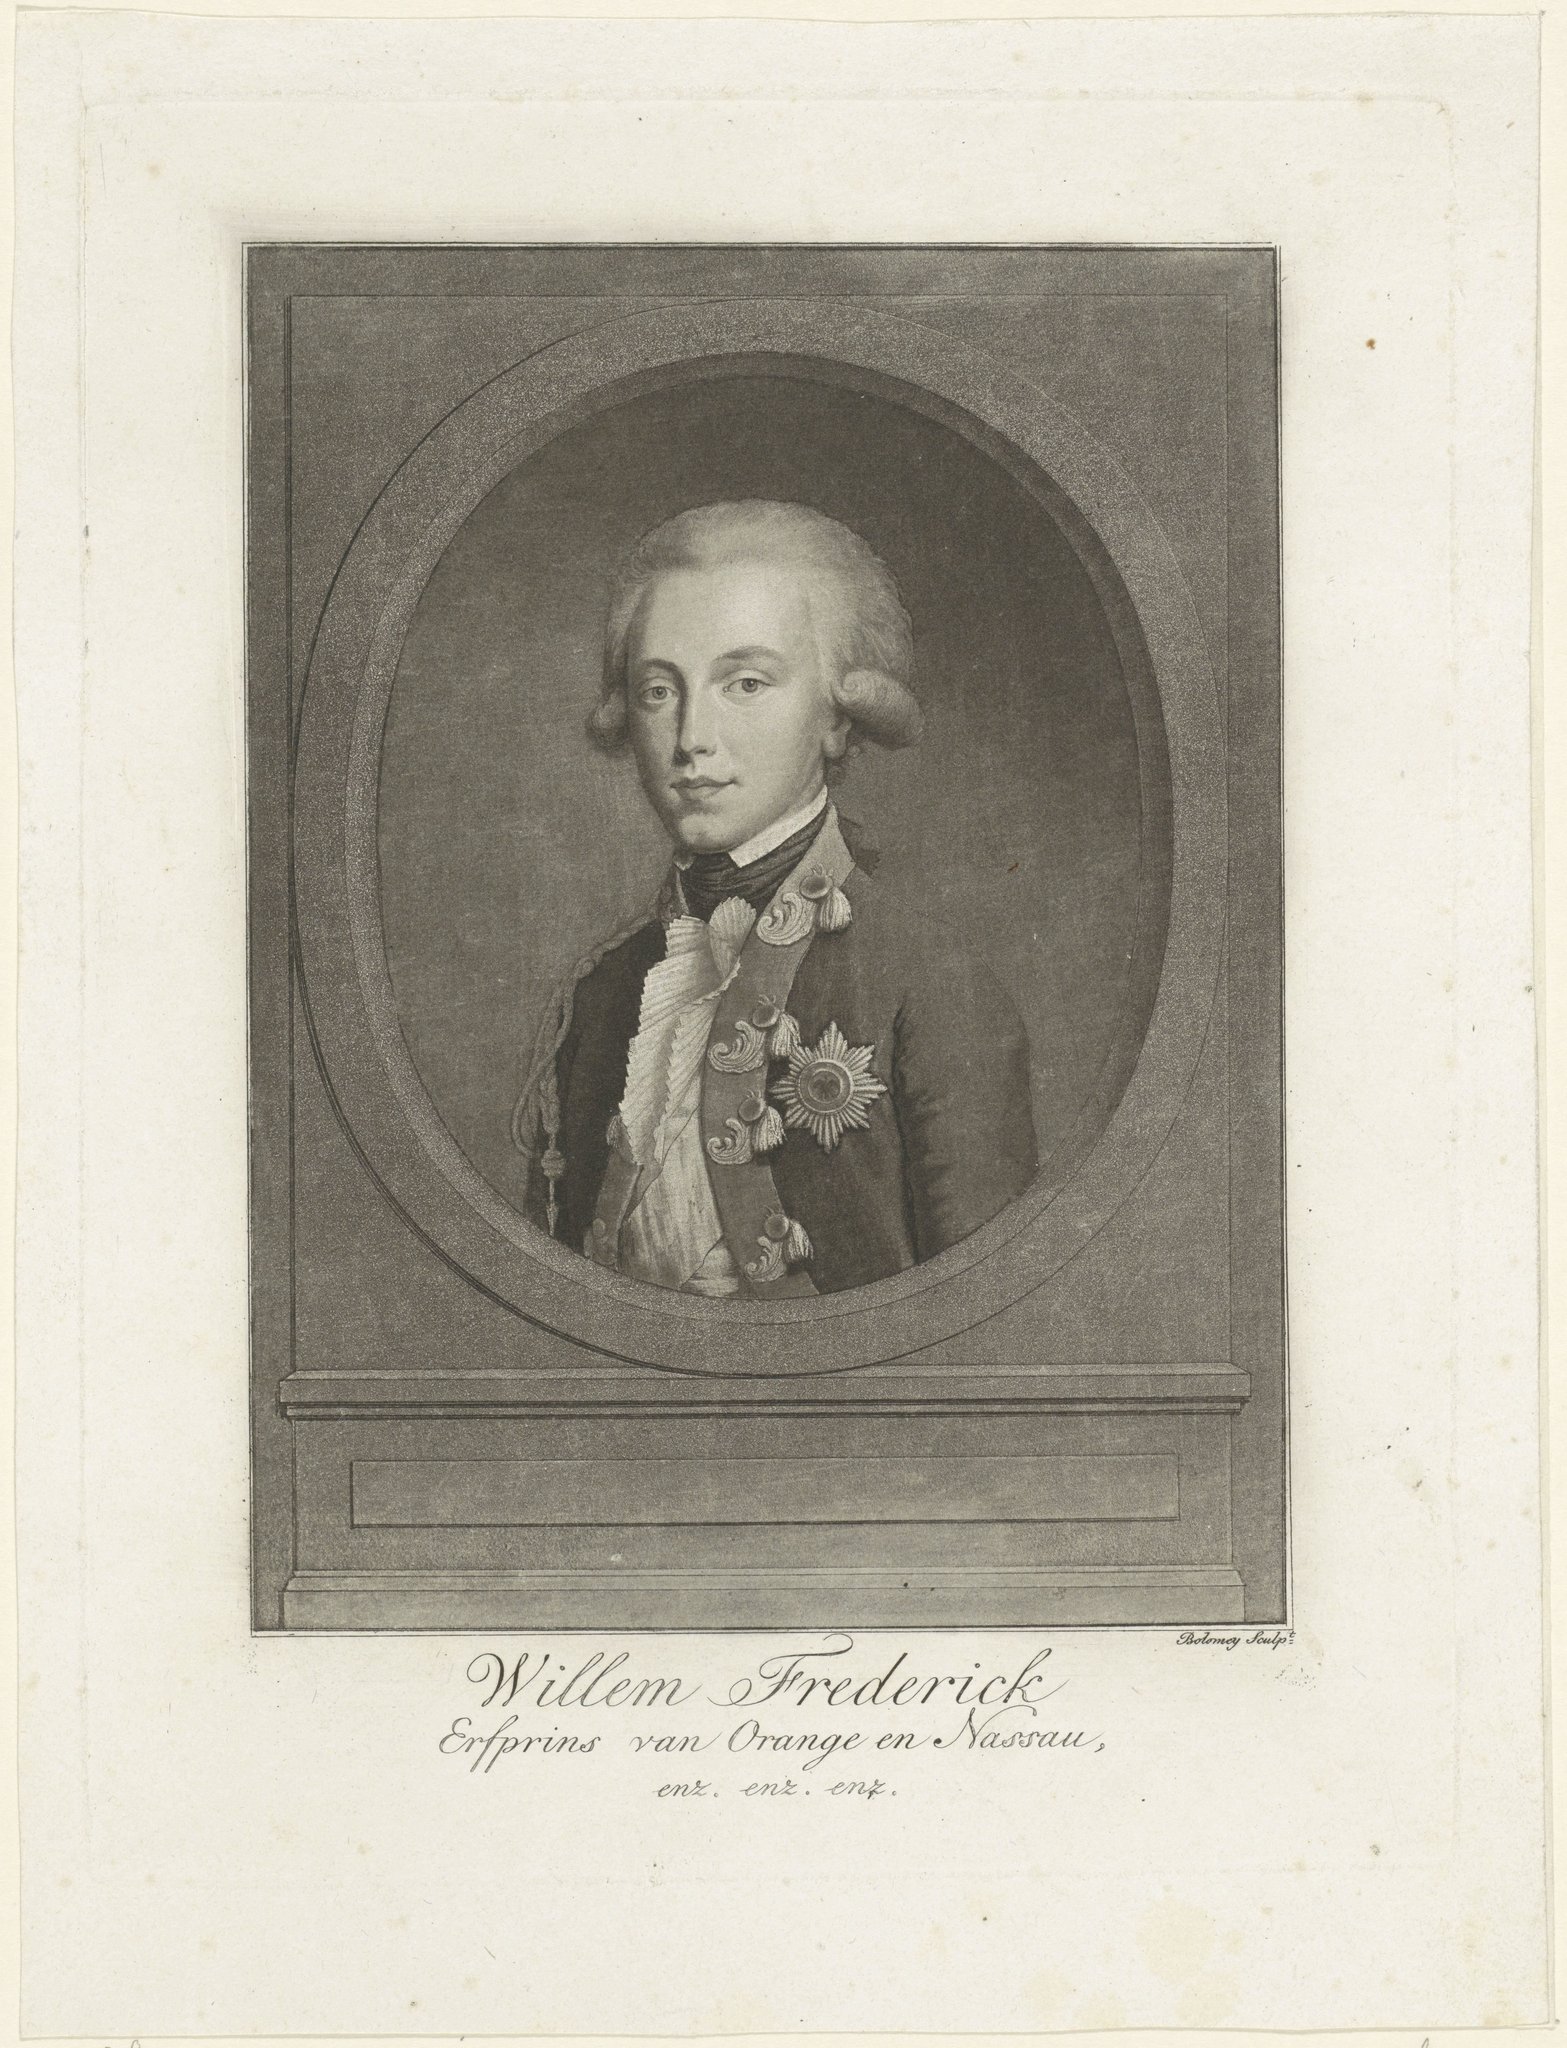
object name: print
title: Portret van Willem I Frederik, koning der Nederlanden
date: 1790-1819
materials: paper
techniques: aquatint, etching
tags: the hague, berlin, william i of the netherlands, knighthood order (with name) - insignia of a knighthood order, e.g.: badge, chain (with name of order)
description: De hier vermelde titel verwijst naar de hoogst verkregen titel van de geportretteerde, niet per se naar de titel die de geportretteerde op deze voorstelling draagt.